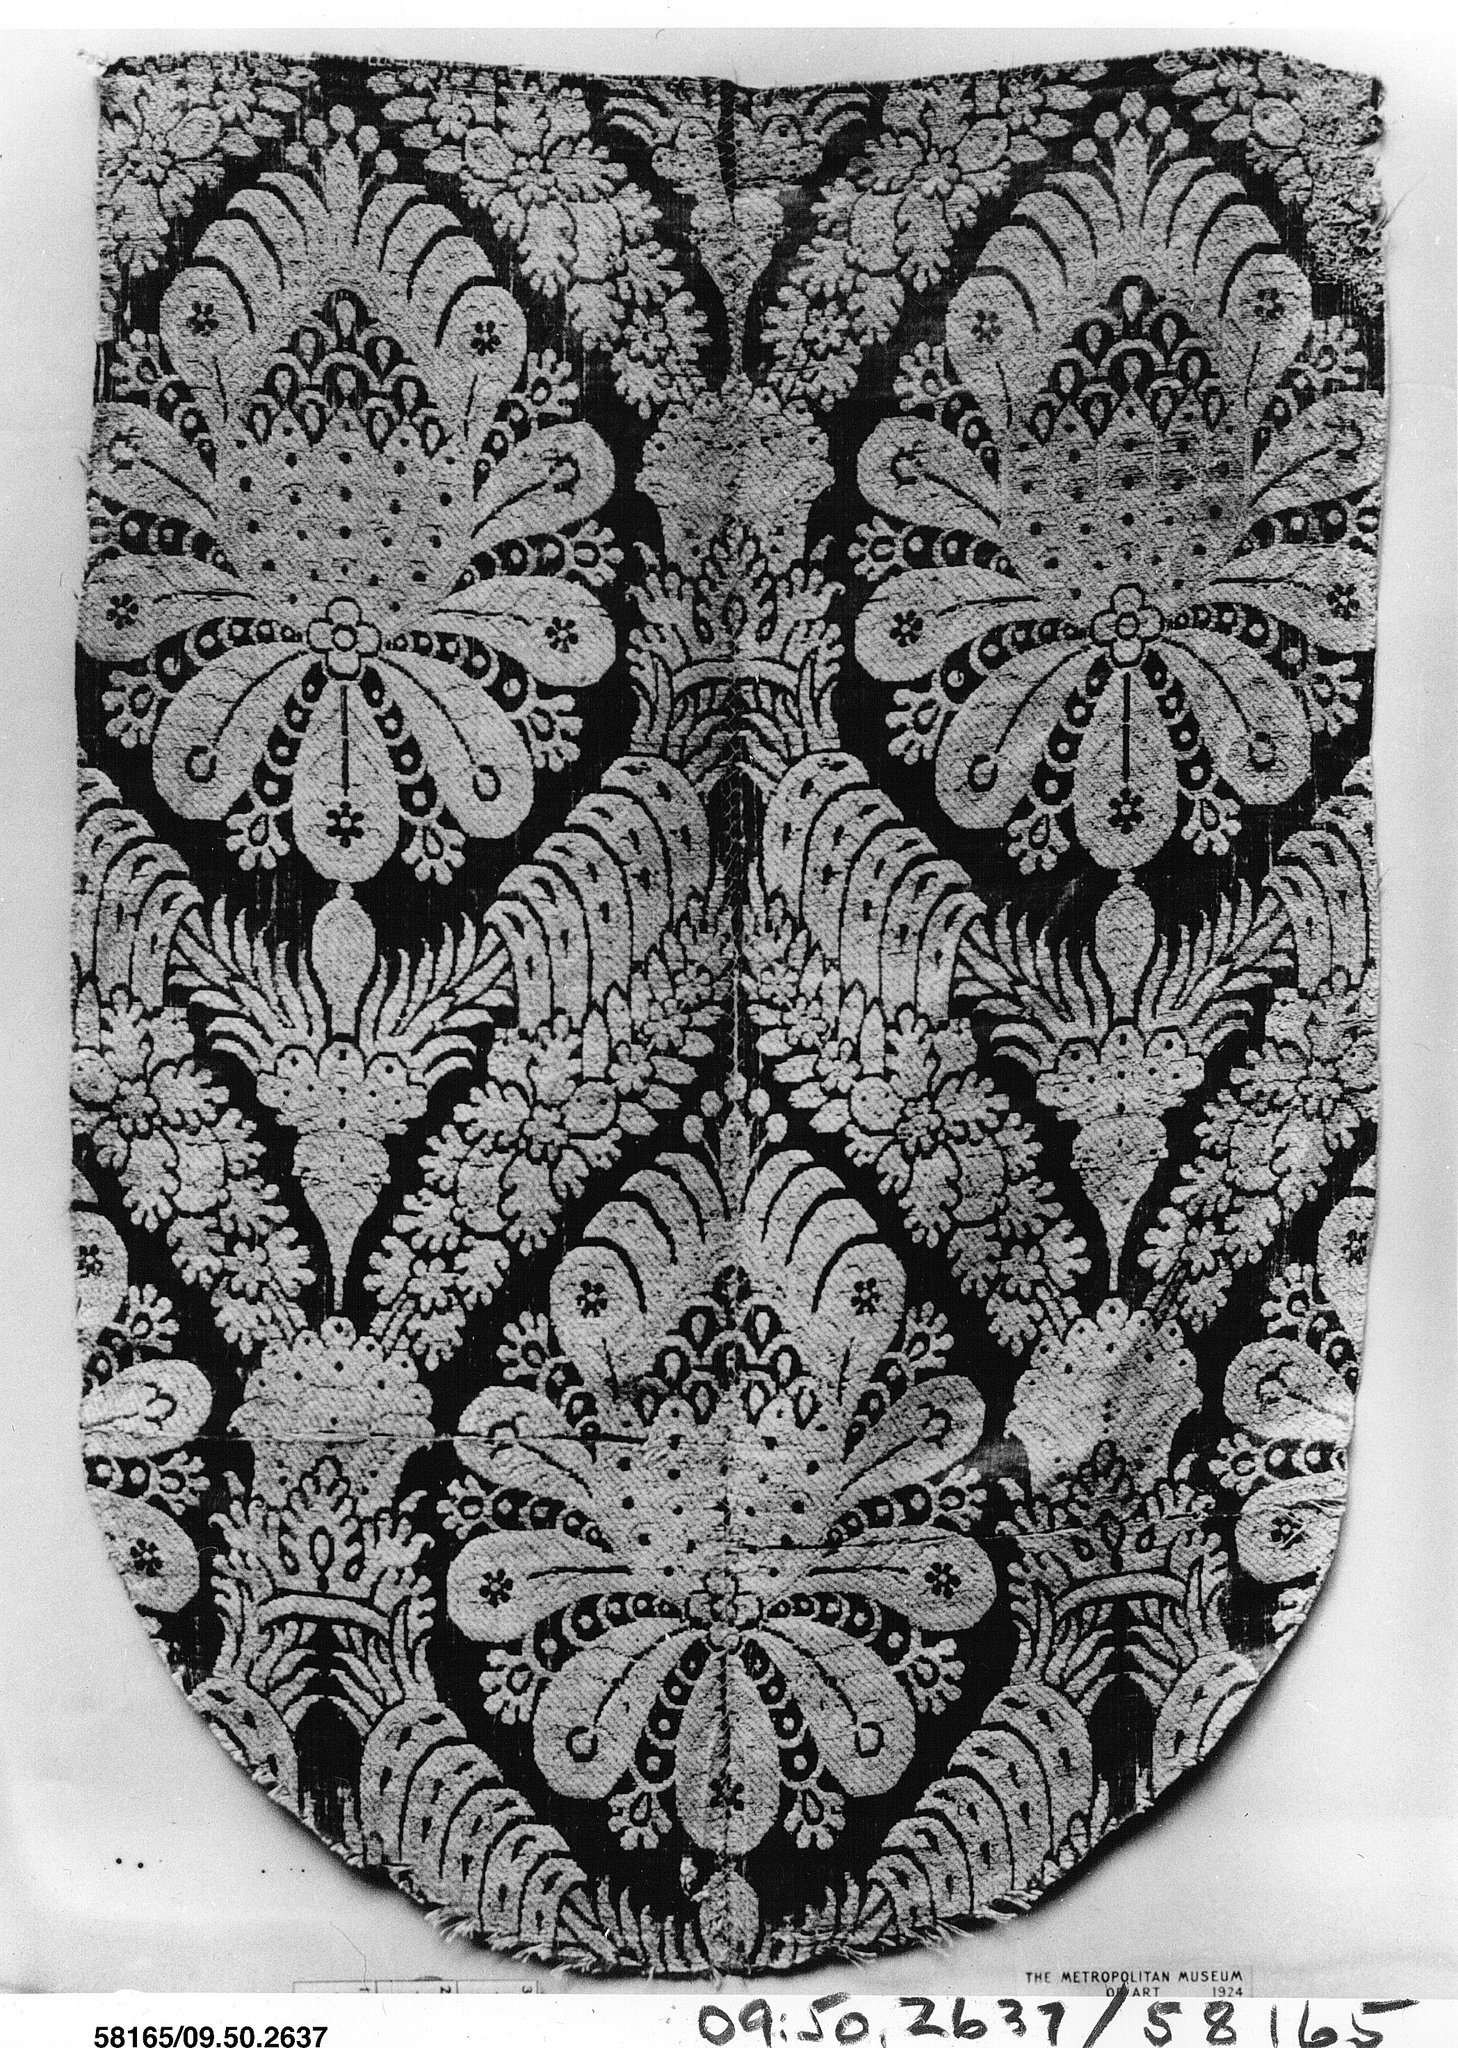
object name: piece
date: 1601-1700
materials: linen, silk